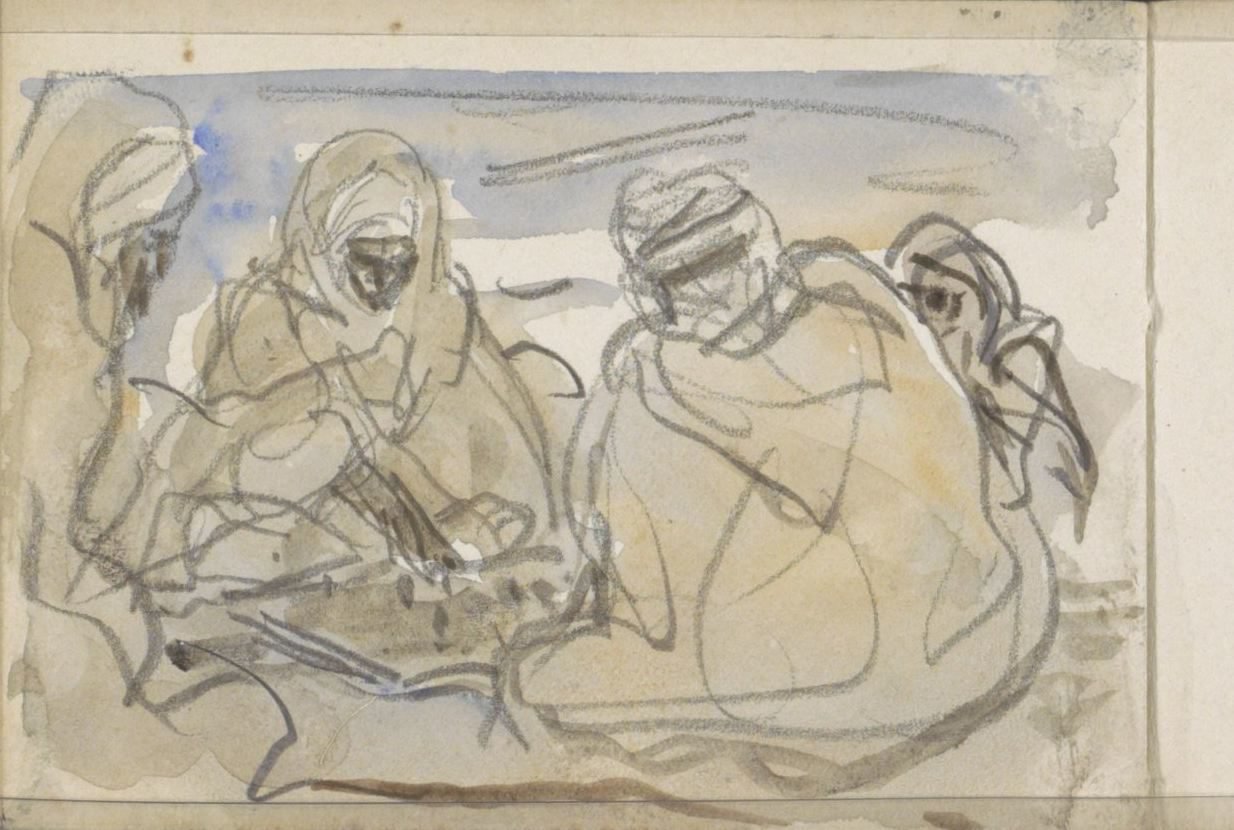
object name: sketchbook leaf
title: Algerijnse mannen, zittend in een kring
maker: marius bauer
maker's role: draughtsman, print maker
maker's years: 1867-1932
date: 1922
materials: paper, pencil, watercolor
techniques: brush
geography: biskra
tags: sitting figure, africans, adult man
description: De mannen dragen traditioneel Noord-Afrikaans kostuum. Pagina 50 uit een schetsboek met 32 bladen.